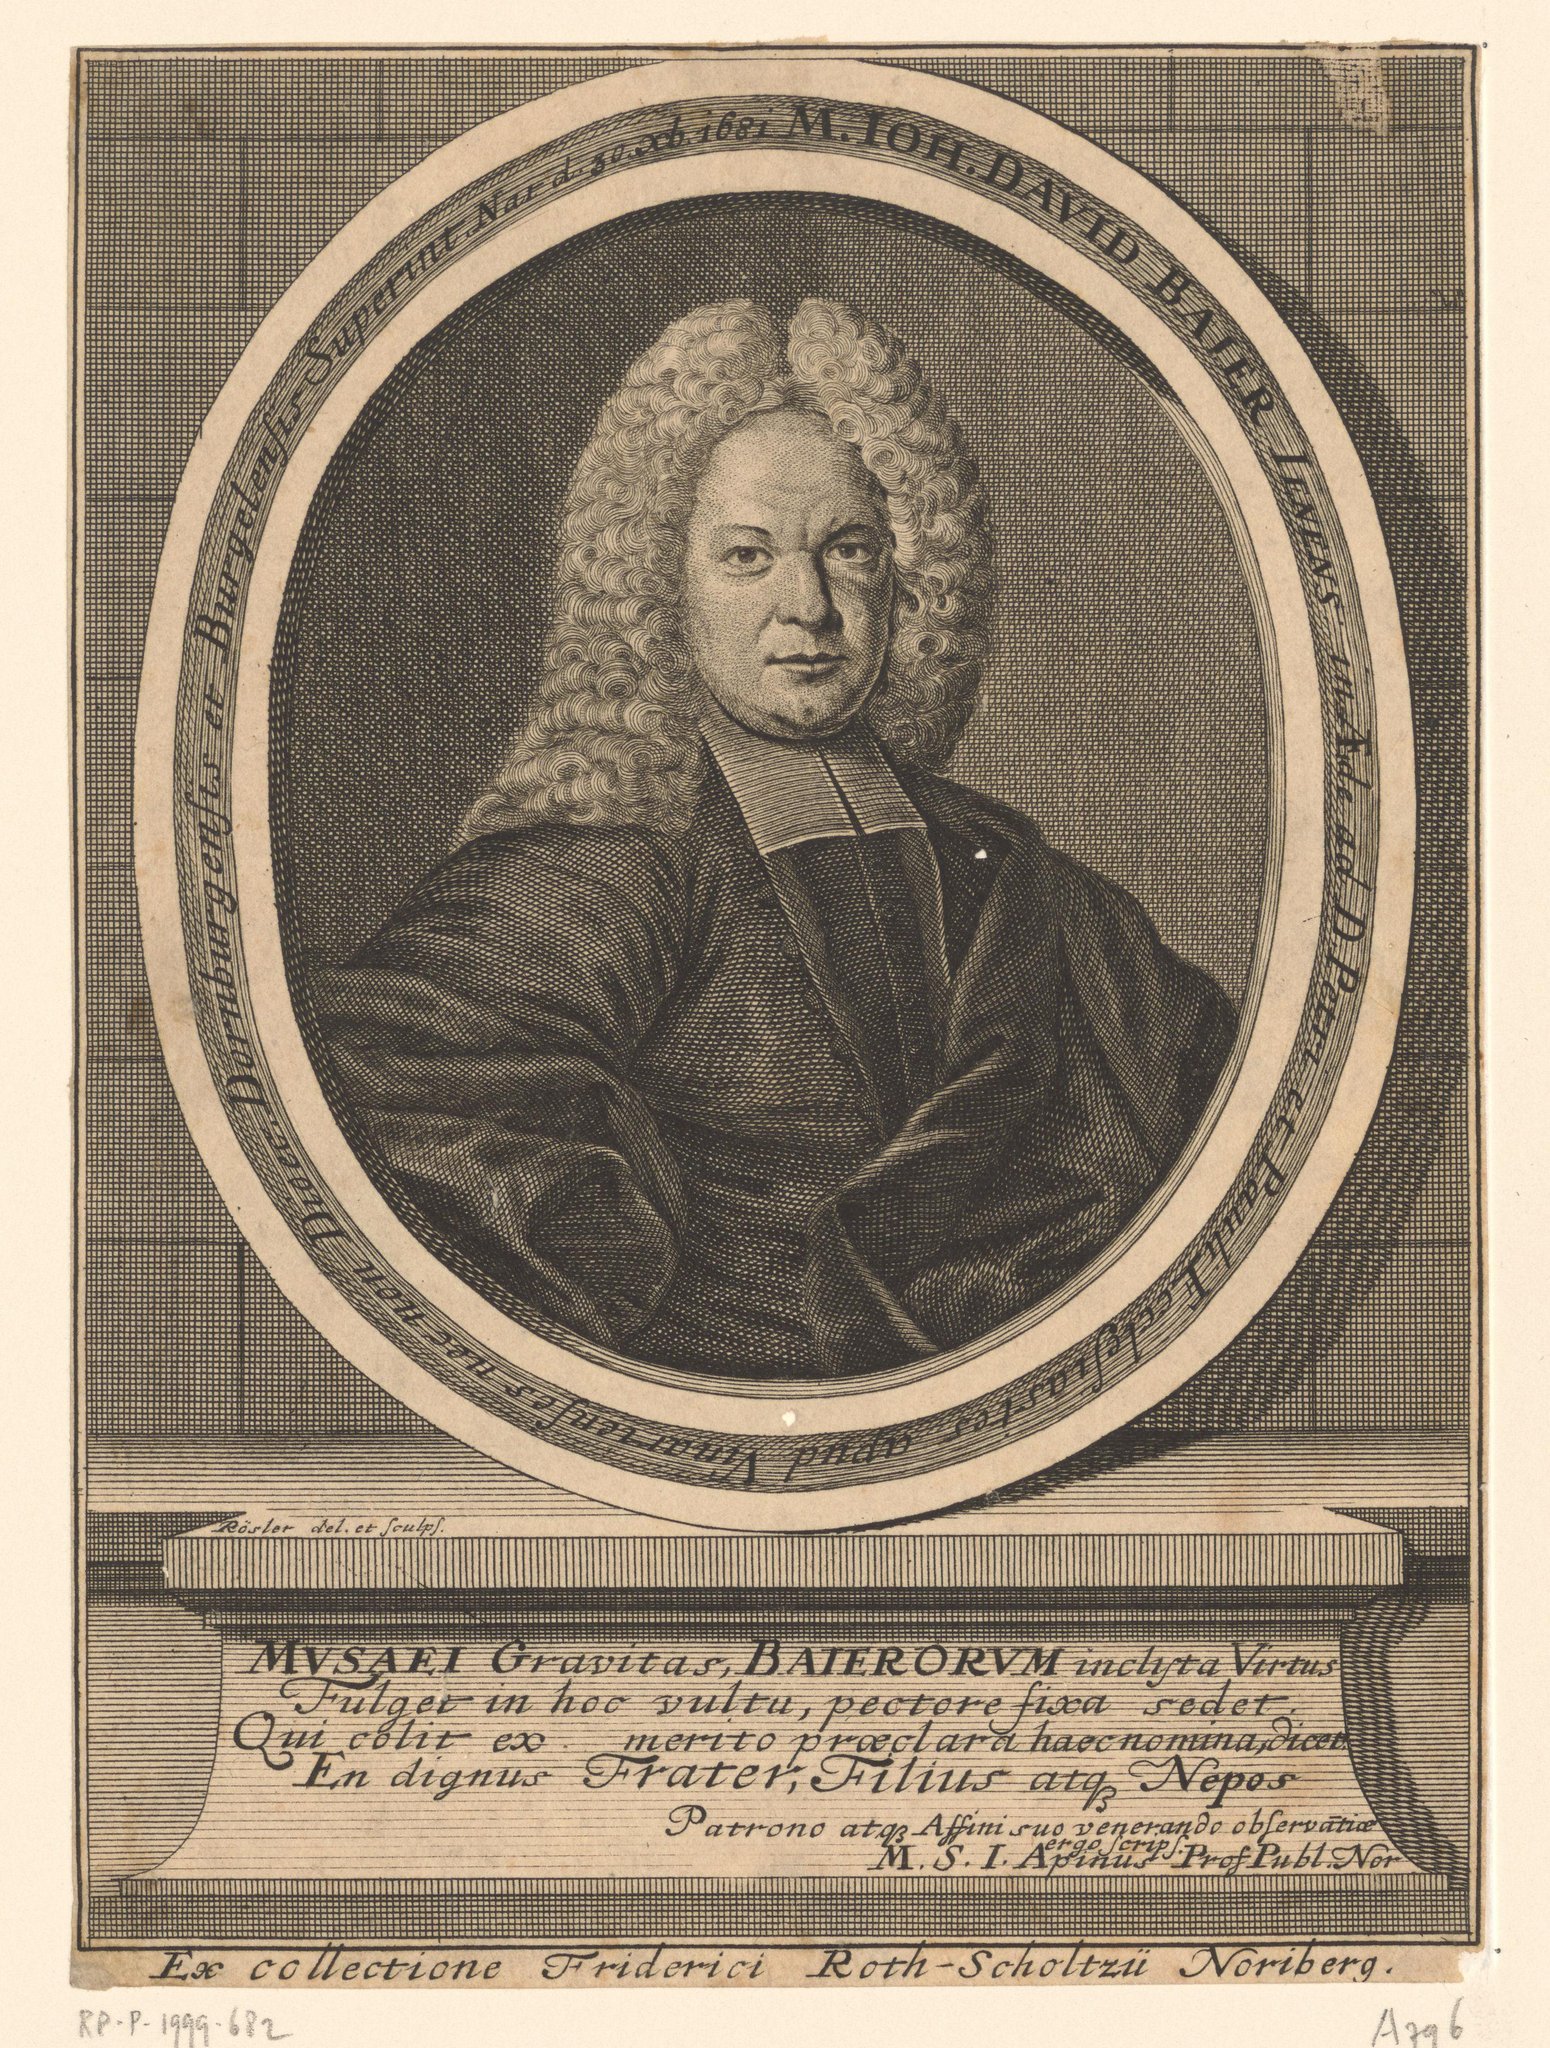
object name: print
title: Portret van Johann David Baier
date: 1715-1777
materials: paper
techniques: engraving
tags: historical persons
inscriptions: collector's mark: Lugt 2228, collector's mark: Lugt 2760